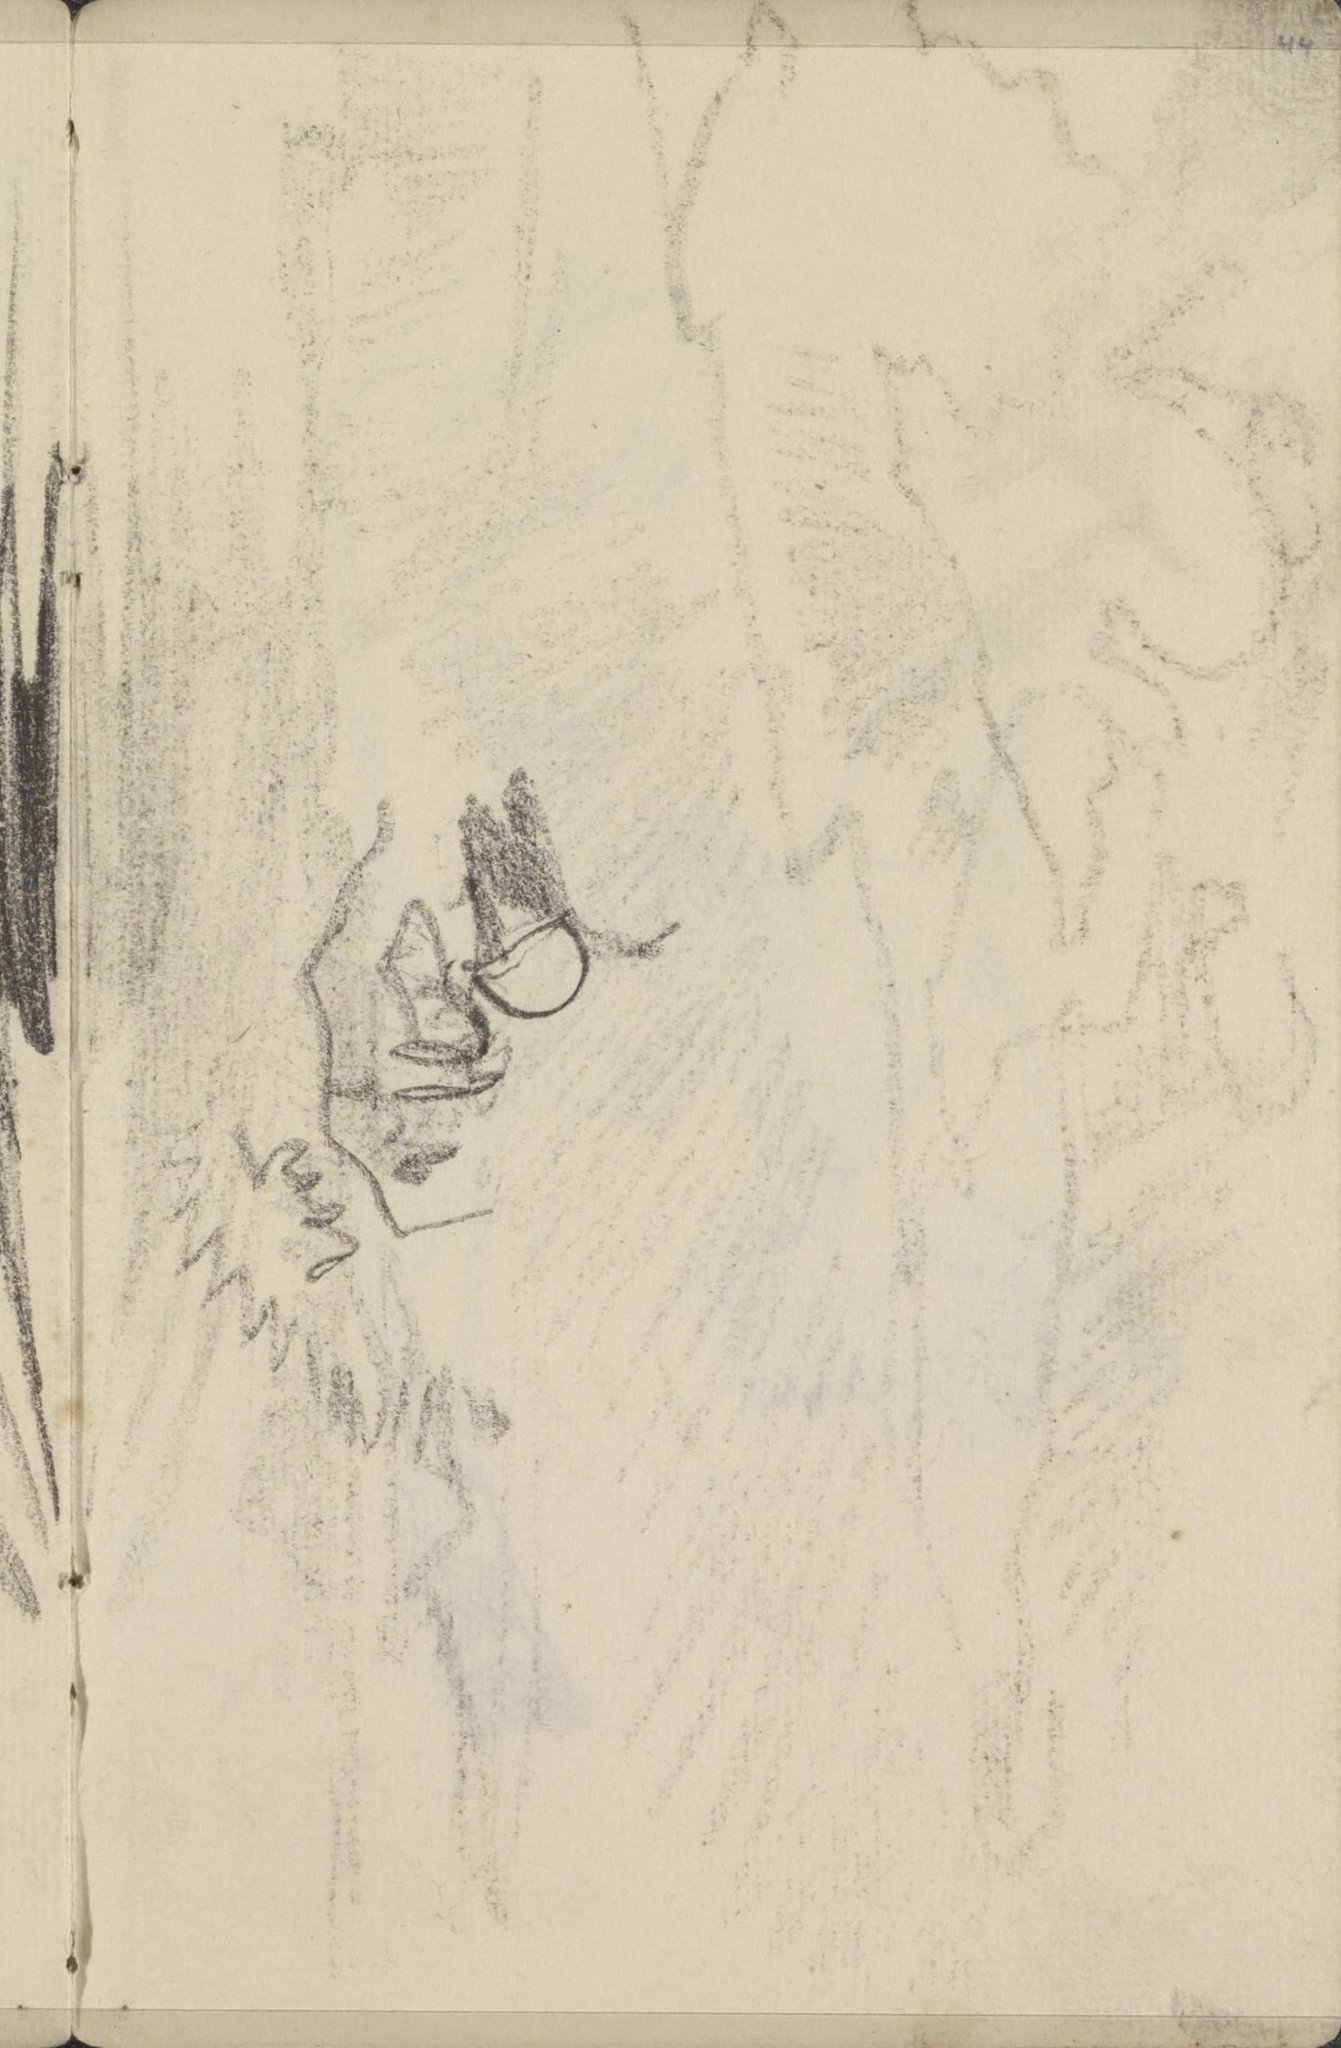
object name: sketchbook leaf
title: Studie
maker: george hendrik breitner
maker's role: draughtsman, painter, print maker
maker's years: 1857-1923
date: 1883-1884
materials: chalk, paper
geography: the hague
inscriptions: kleurnotitie, handgeschreven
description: Pagina 44 uit een schetsboek met 23 bladen.